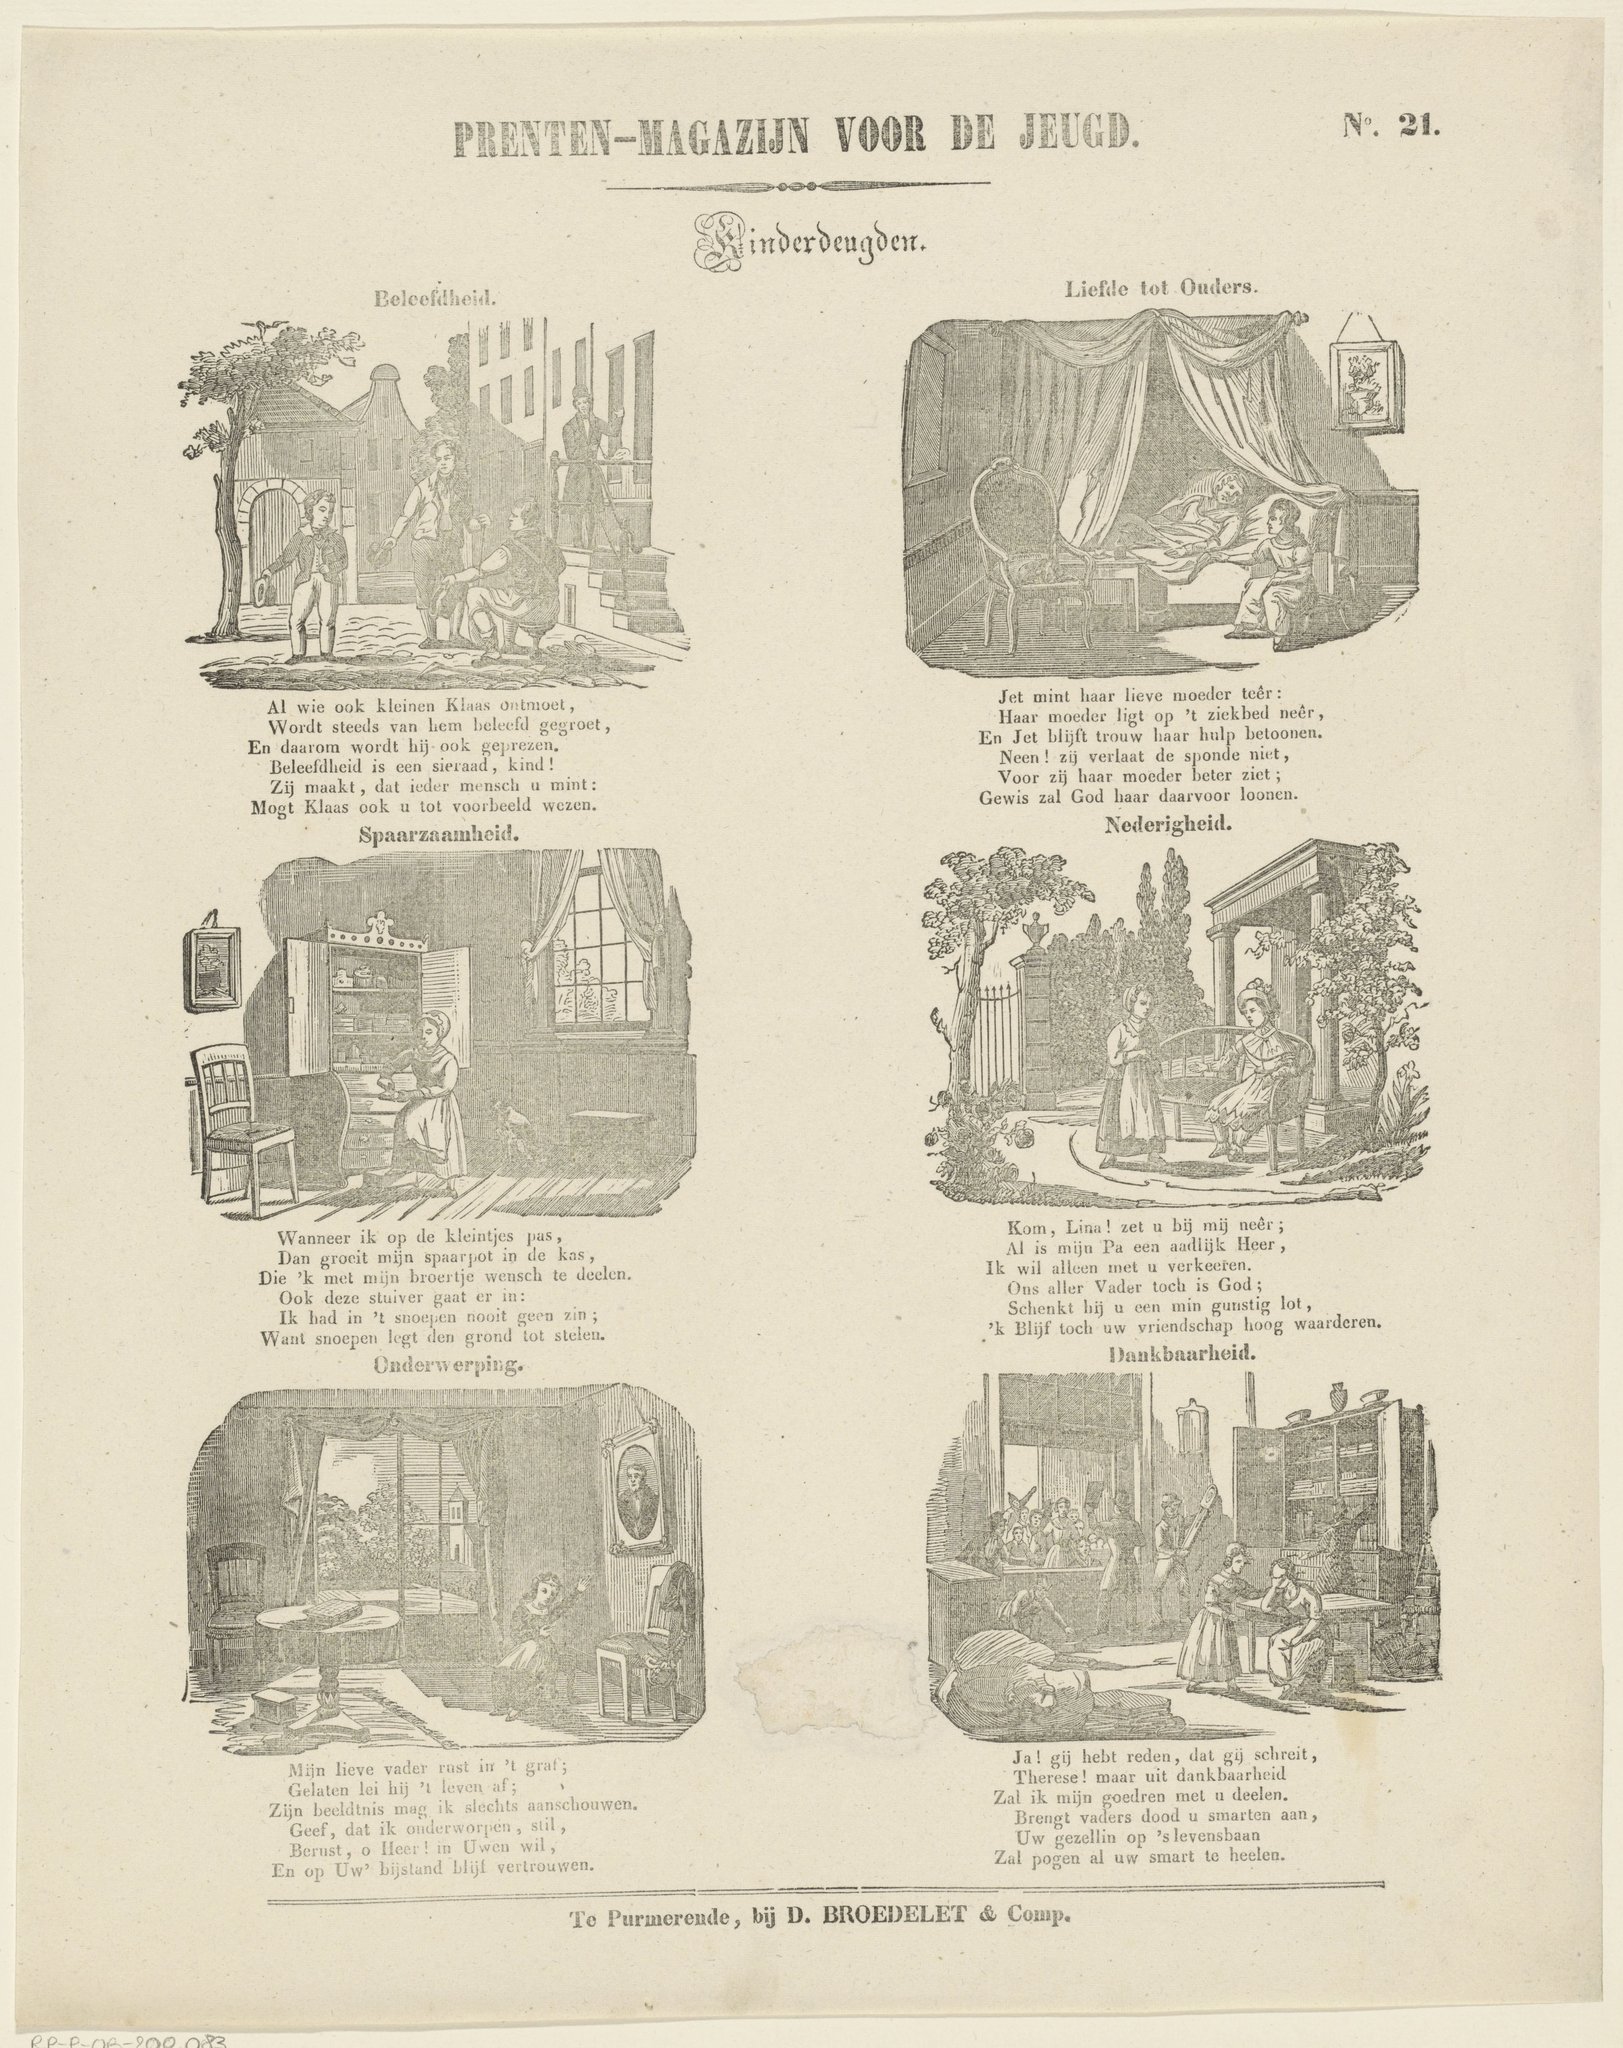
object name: print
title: Kinderdeugden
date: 1839-1841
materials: paper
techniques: letterpress printing, engraving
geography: purmerend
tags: good behaviour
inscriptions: collector's mark: Lugt 2760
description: Blad met 6 voorstellingen van kinderdeugden, zoals beleefdheid, spaarzaamheid en dankbaarheid. Boven elke voorstelling een titel, onder elke voorstelling een zesregelig vers. Genummerd rechtsboven: No. 21.